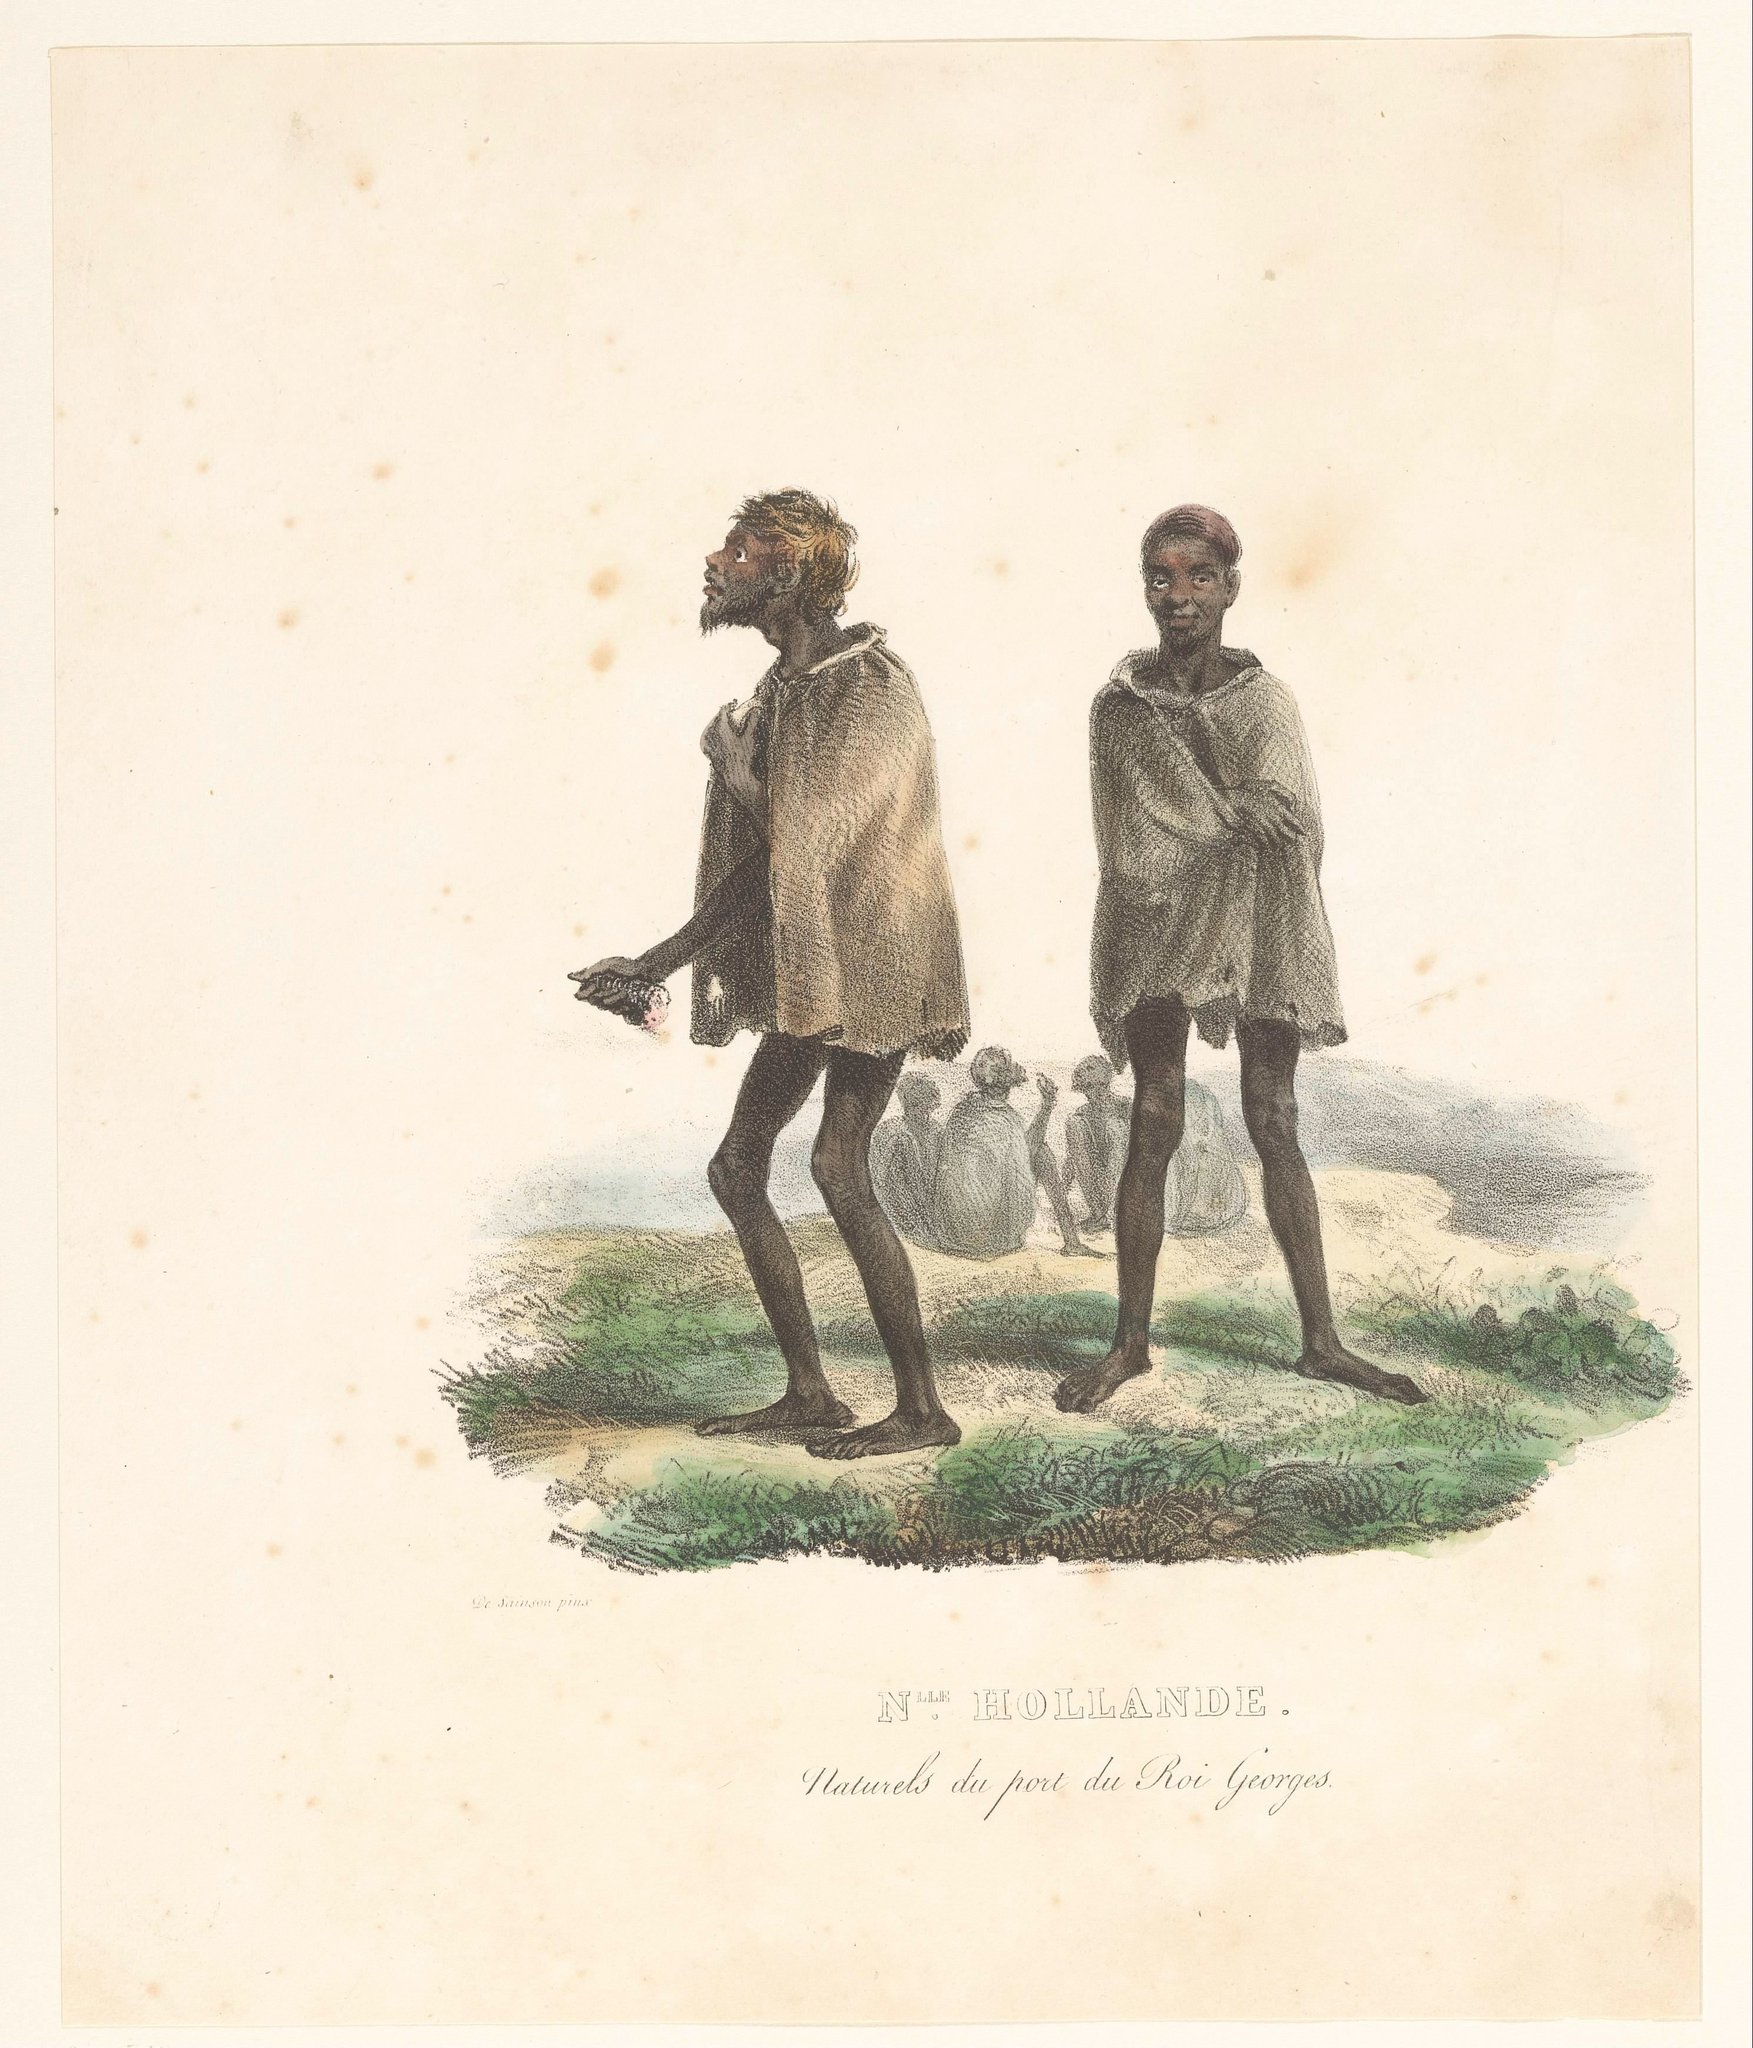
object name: print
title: Ontdekkingsreis van de Astrolabe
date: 1830-1835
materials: paper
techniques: hand coloring, lithograph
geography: paris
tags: australian and oceanian races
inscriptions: collector's mark: Lugt 2228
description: In 1830-1833 werd de publicatie 'Voyage de la corvette l'Astrolabe exécuté par ordre du roi, pendant les années 1826-1827-1828-1829 (...)' in zeventien delen uitgegeven door J. Tastu in Parijs. De auteur van dit verslag van een Franse expeditie met het schip 'l'Astrolabe' was J. Dumont d'Urville. De publicatie was verrijkt met illustraties van verschillende lithografen, naar ontwerp van Louis-Auguste de Sainson, die zelf had deelgenomen aan de expeditie.